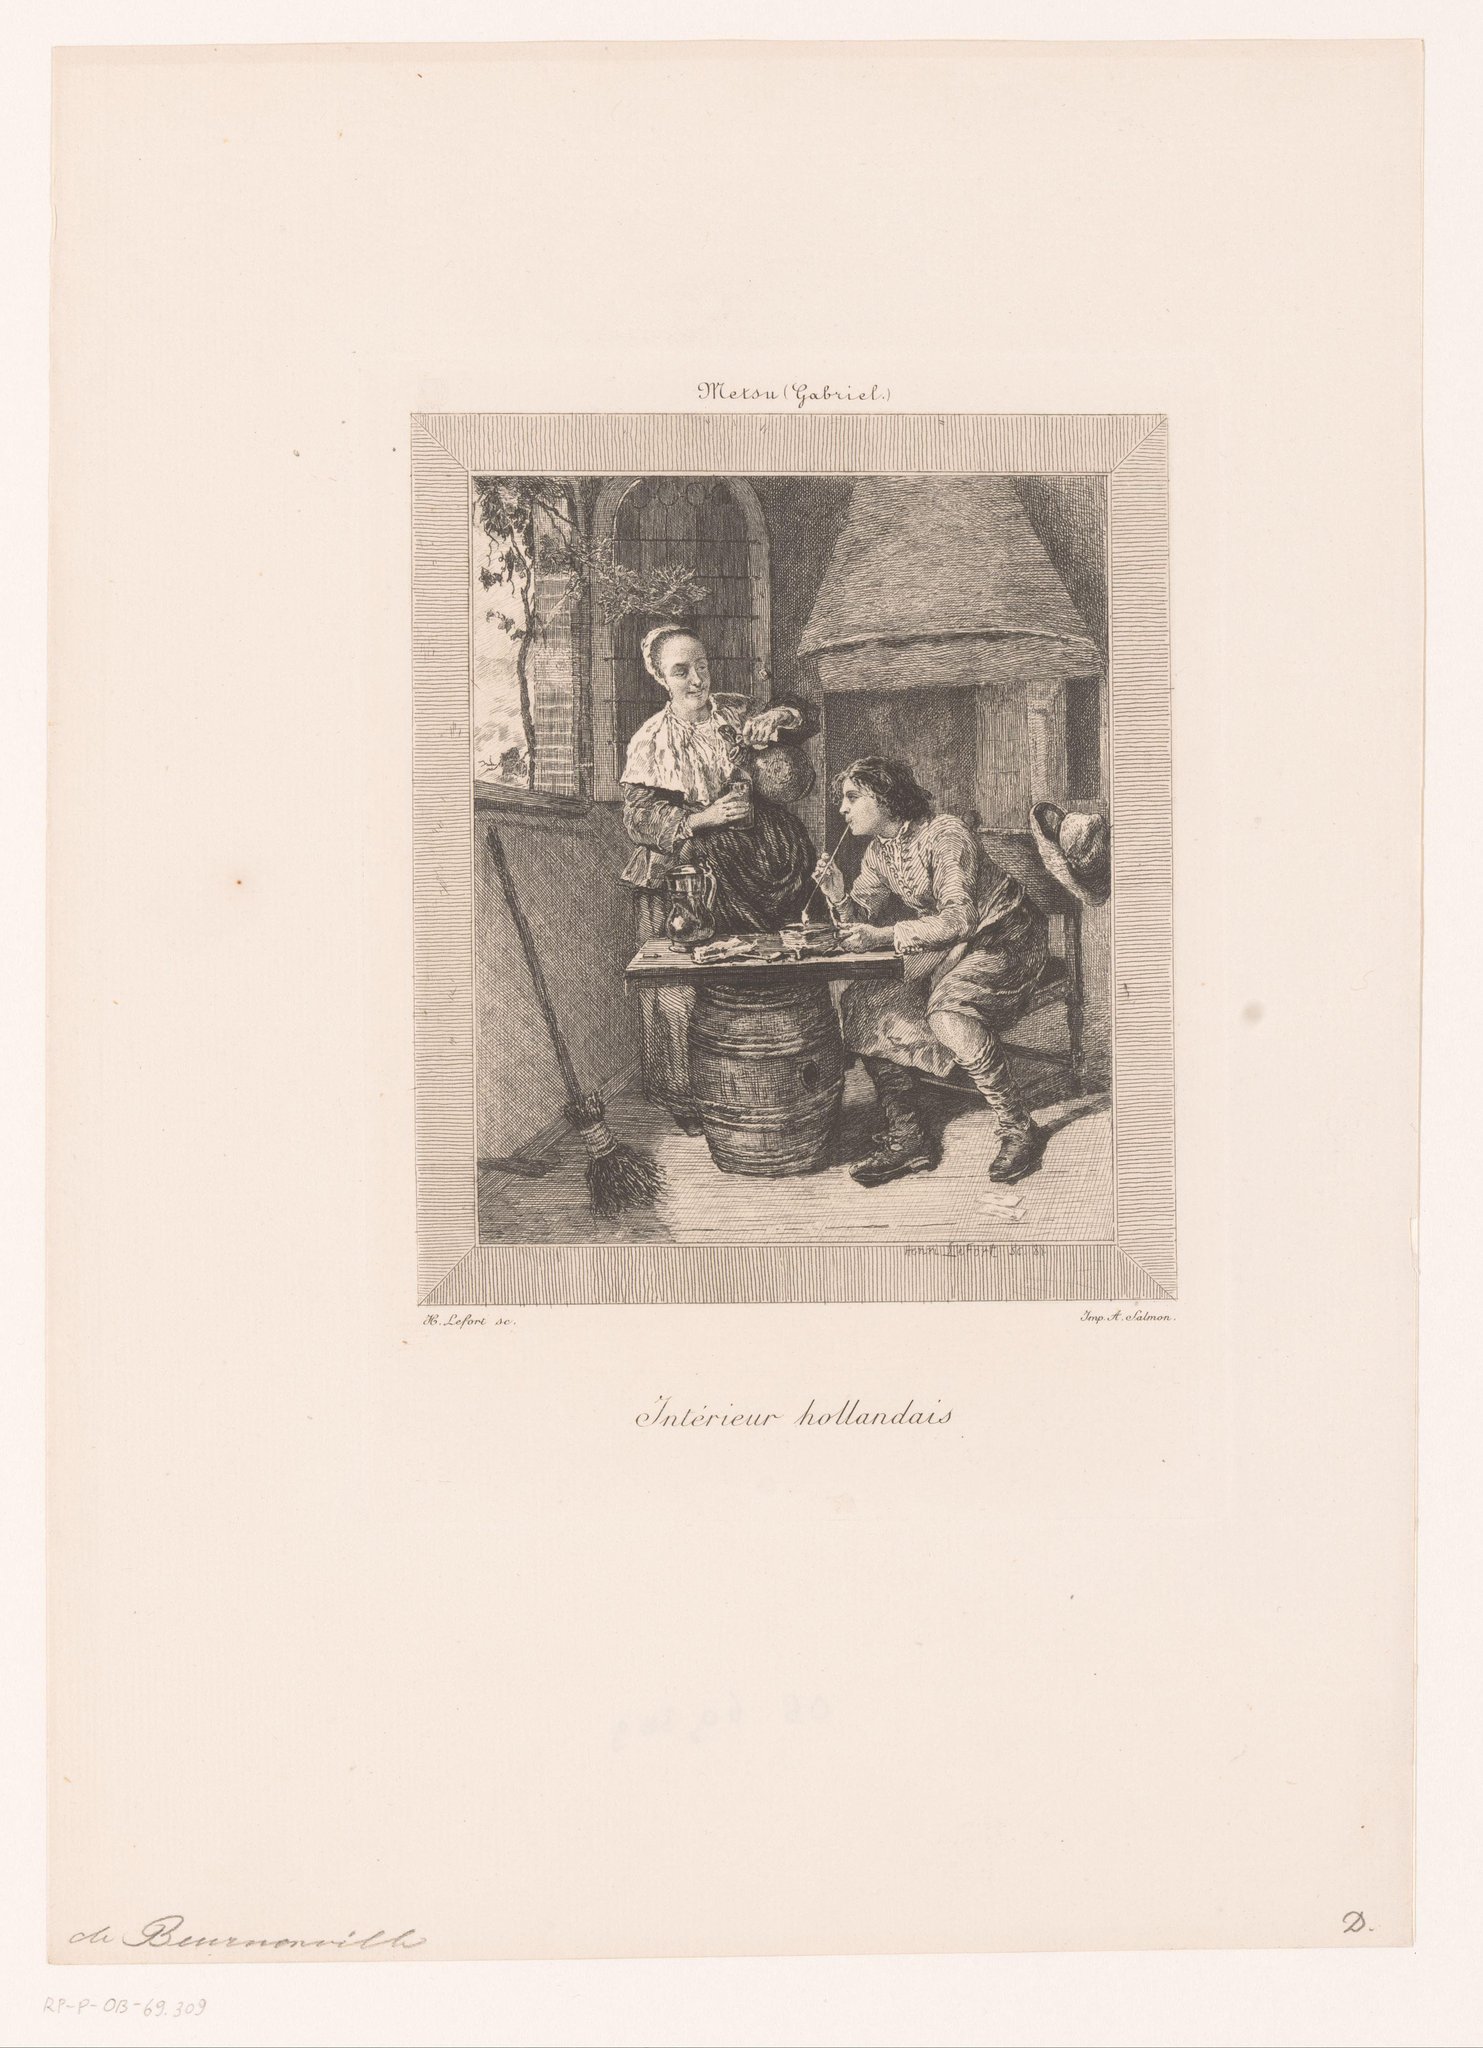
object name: print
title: Intérieur hollandais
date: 1881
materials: paper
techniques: engraving, etching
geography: paris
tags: interior of the house, open window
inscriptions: collector's mark: Lugt 2228